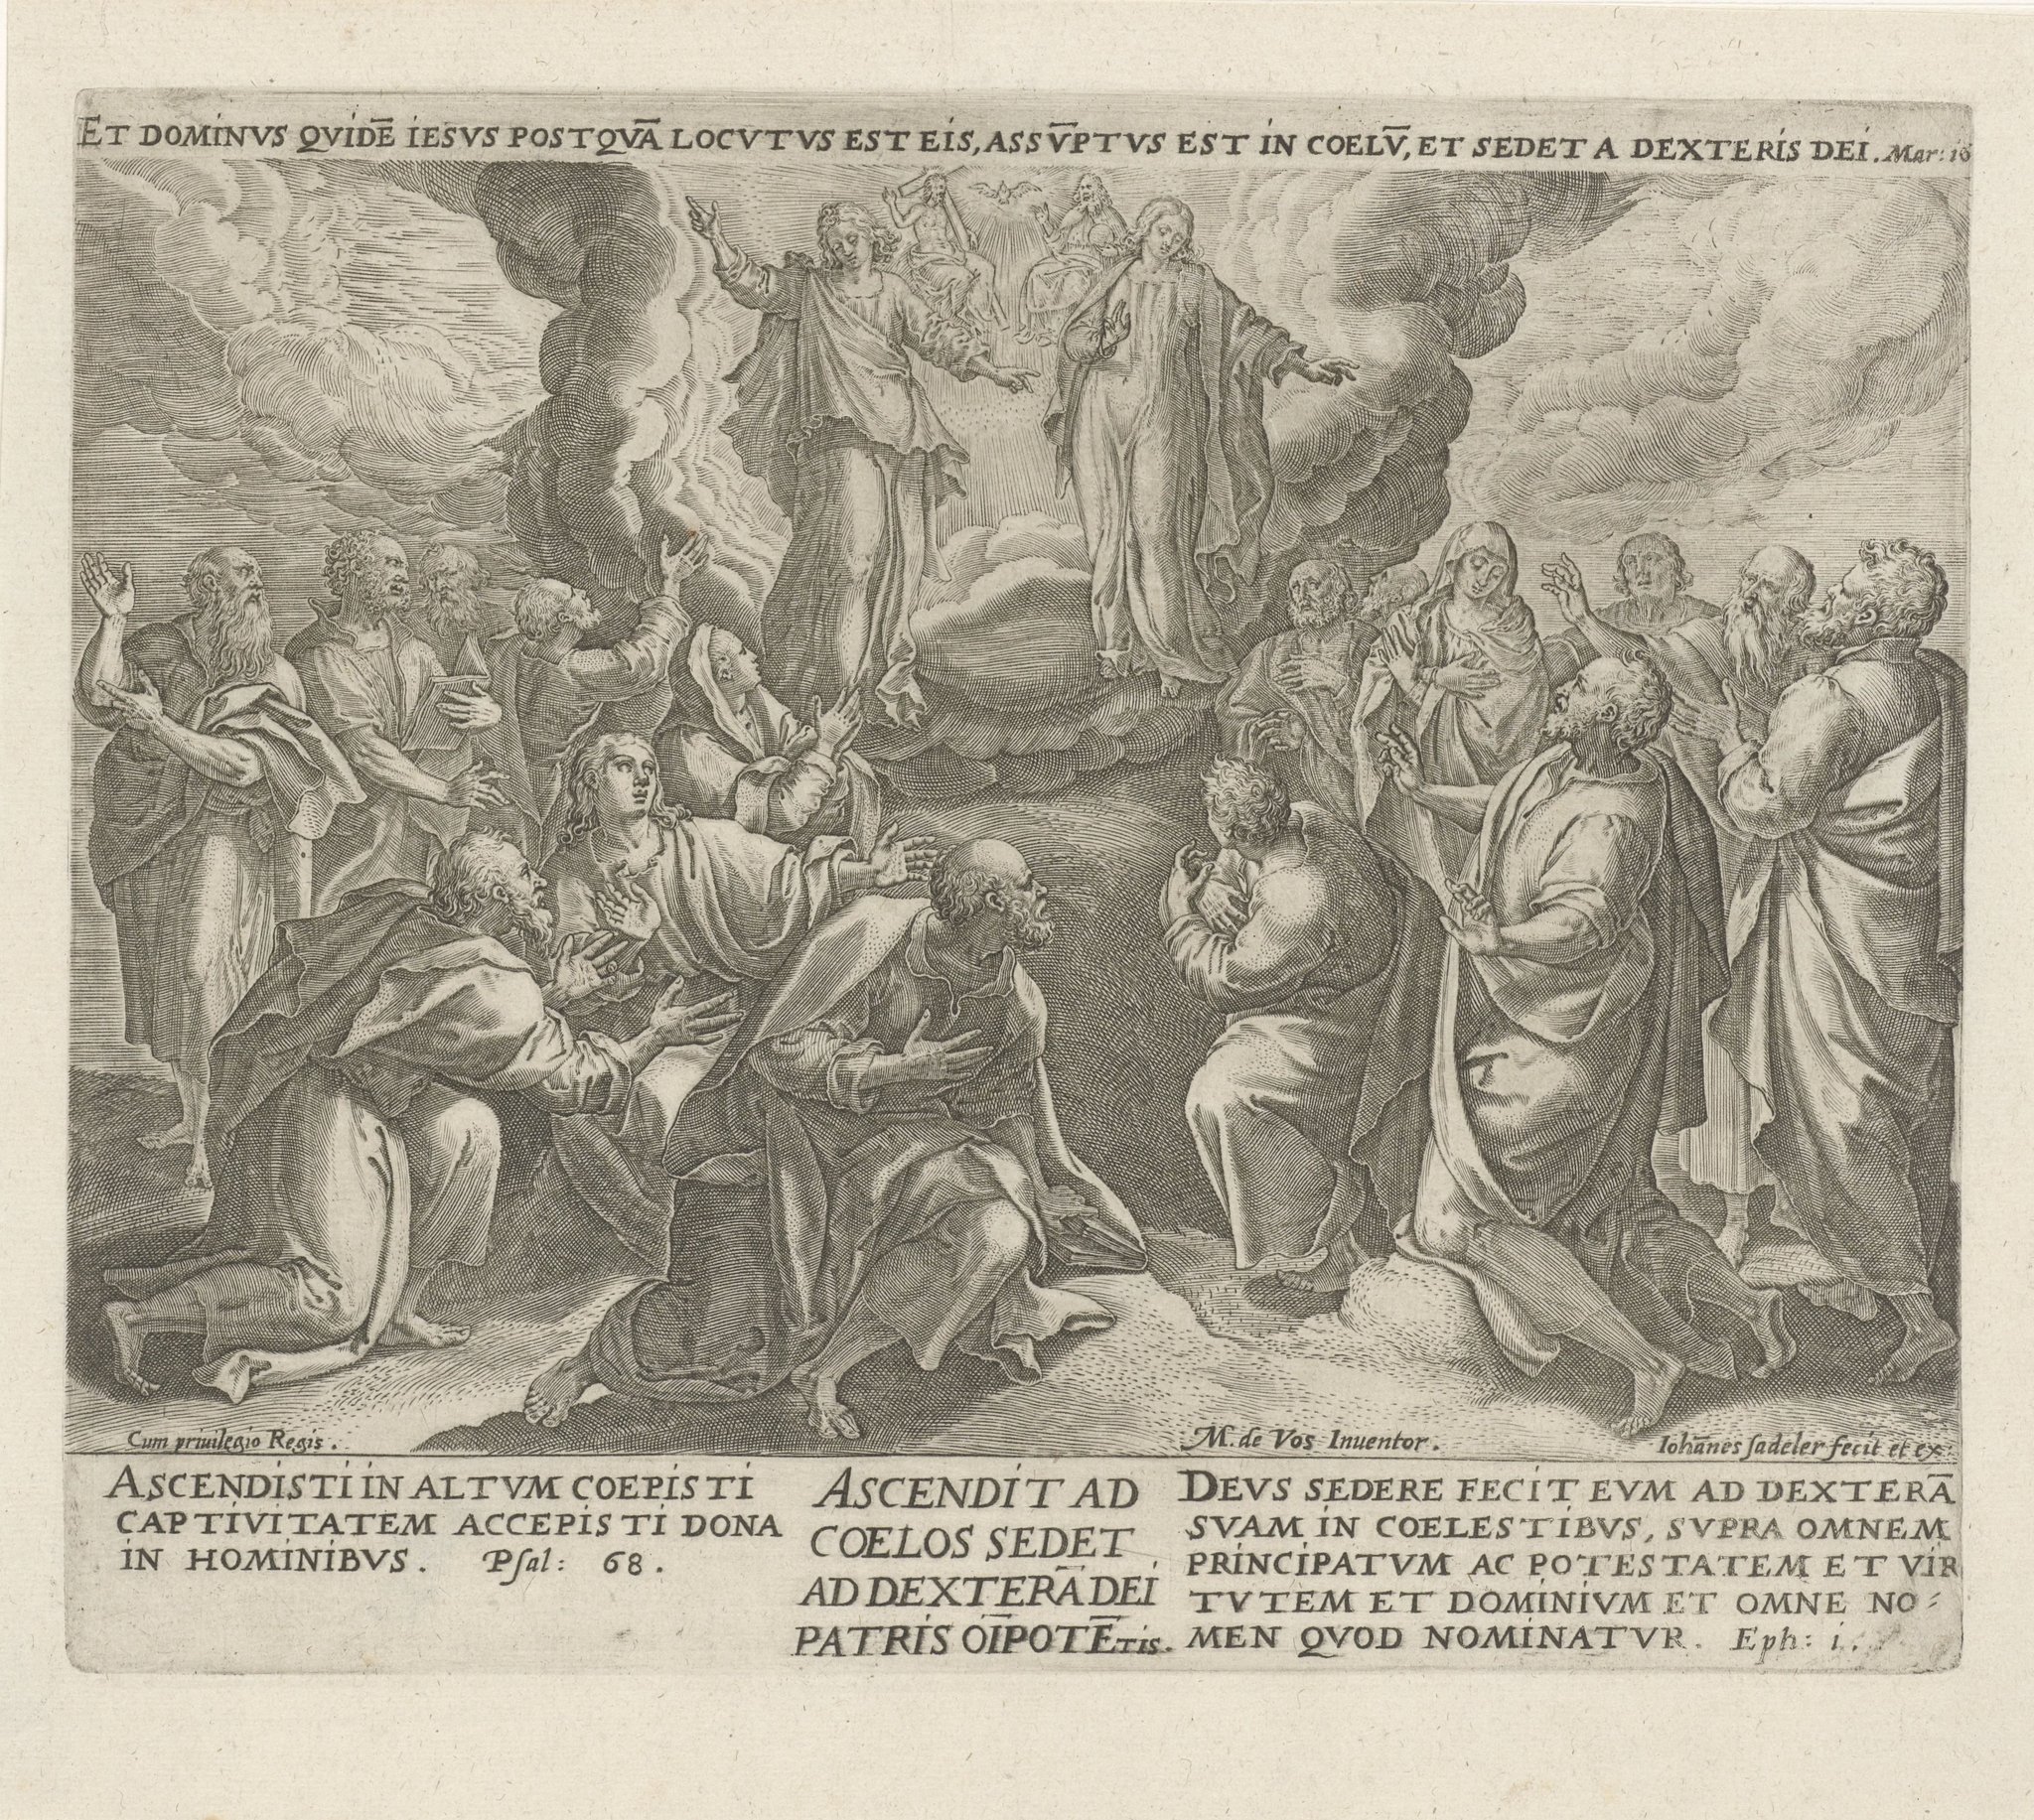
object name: print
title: Hemelvaart van Christus: 'die opgestegen is ten hemel, zit aan de rechterhand van God, de almachtige Vader'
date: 1579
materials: paper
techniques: engraving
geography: cologne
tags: christ ascends into heaven; apostles (and mary) beneath (+ angel(s)), trinity in which god the father and christ are represented as persons, the holy ghost as dove, 'ascendit ad coelos, sedet ad dexteram patris omnipotentis' ~ articles of faith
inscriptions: collector's mark: Lugt 240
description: Het zesde geloofsartikel: het geloof in de hemelvaart van Christus. De prent toont twee engelen in de wolken die de apostelen van Christus en de maagd Maria een visioen tonen van de Heilige Drie-eenheid. De prent heeft een Latijns opschrift met een Bijbelcitaat dat refereert naar het afgebeelde Bijbelverhaal en een Latijns onderschrift over de apostolische geloofsbelijdenis. De zesde prent in een twaalfdelige serie over het credo.